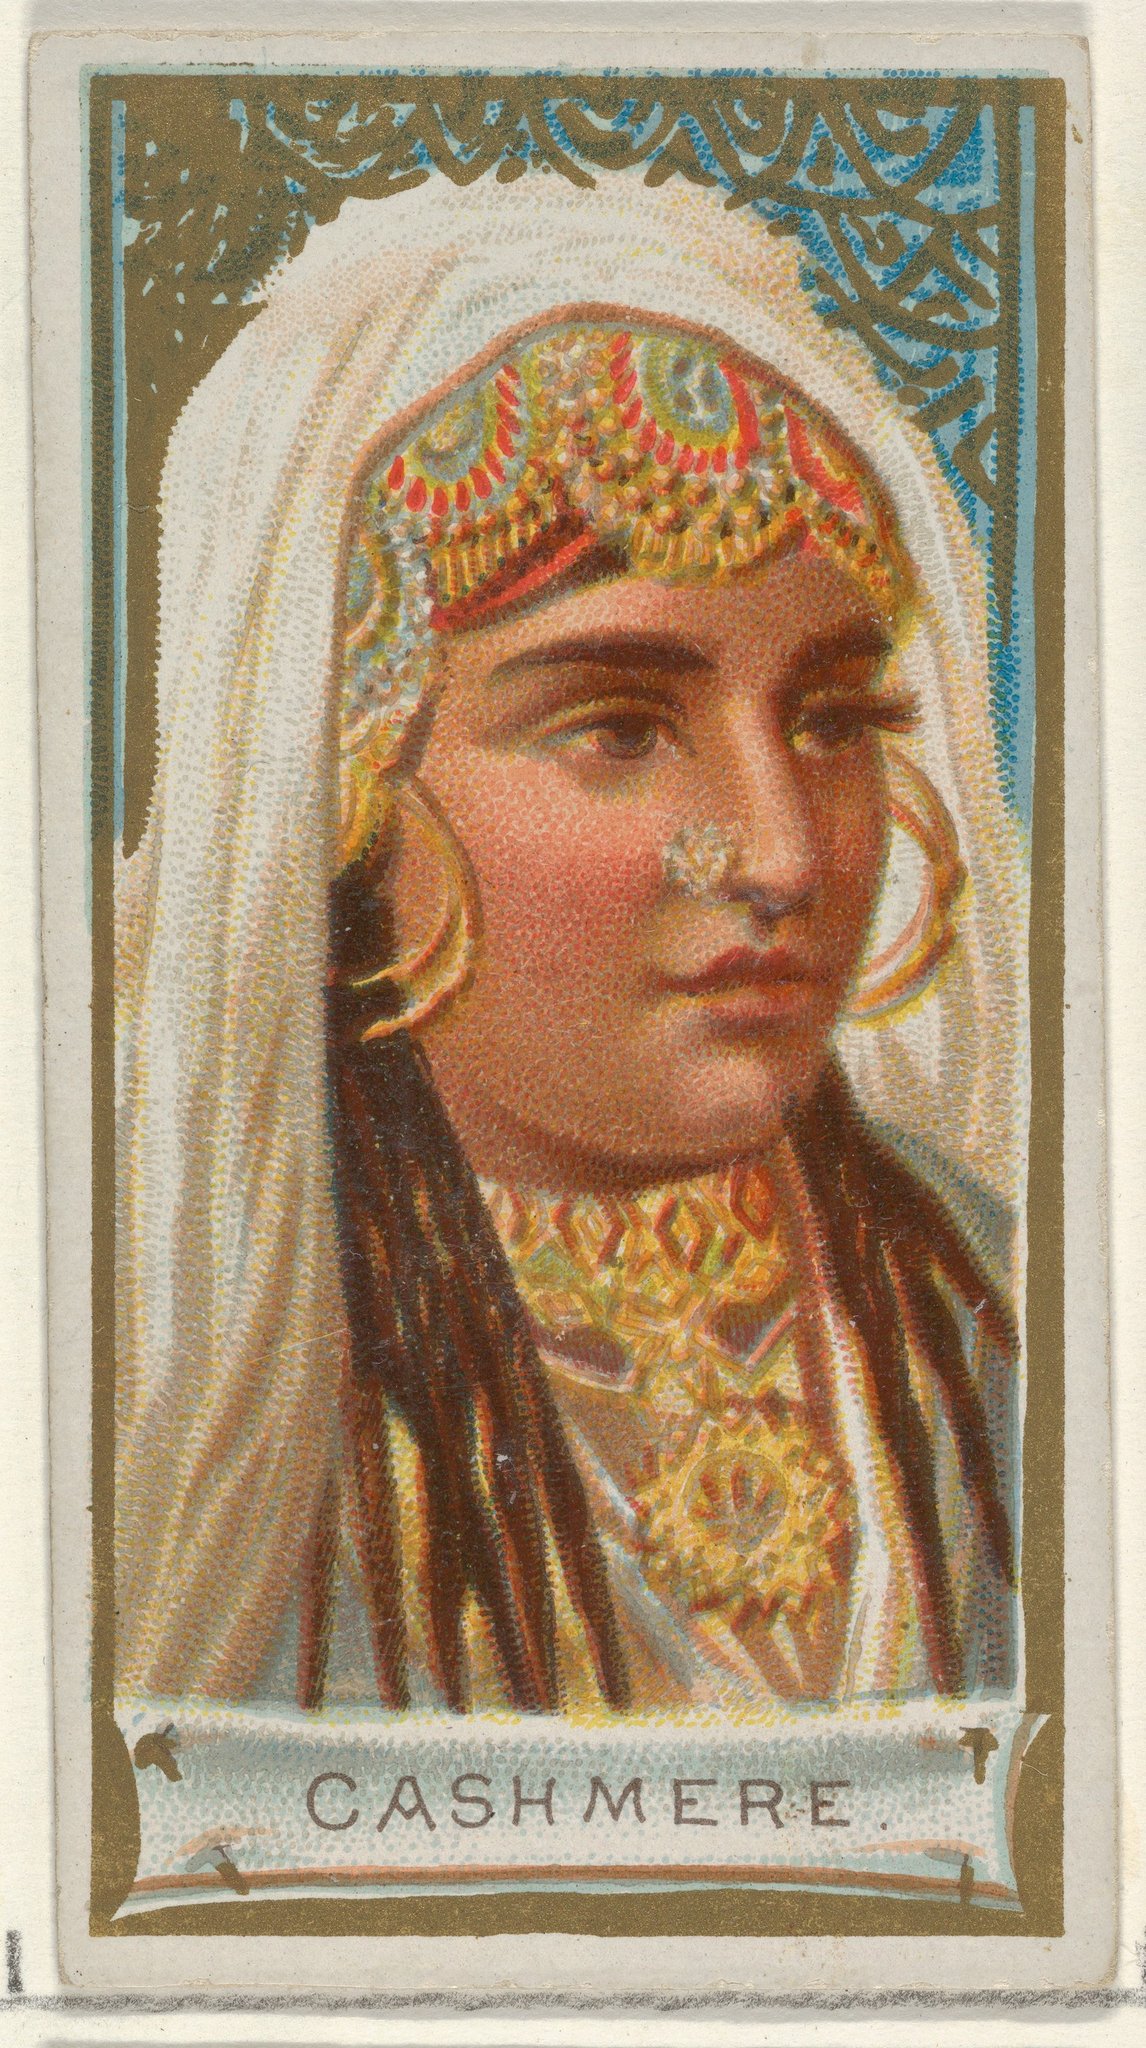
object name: print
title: Cashmere, from the Types of All Nations series (N24) for Allen & Ginter Cigarettes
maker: allen & ginter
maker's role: publisher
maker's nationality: american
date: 1889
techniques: color lithograph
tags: women